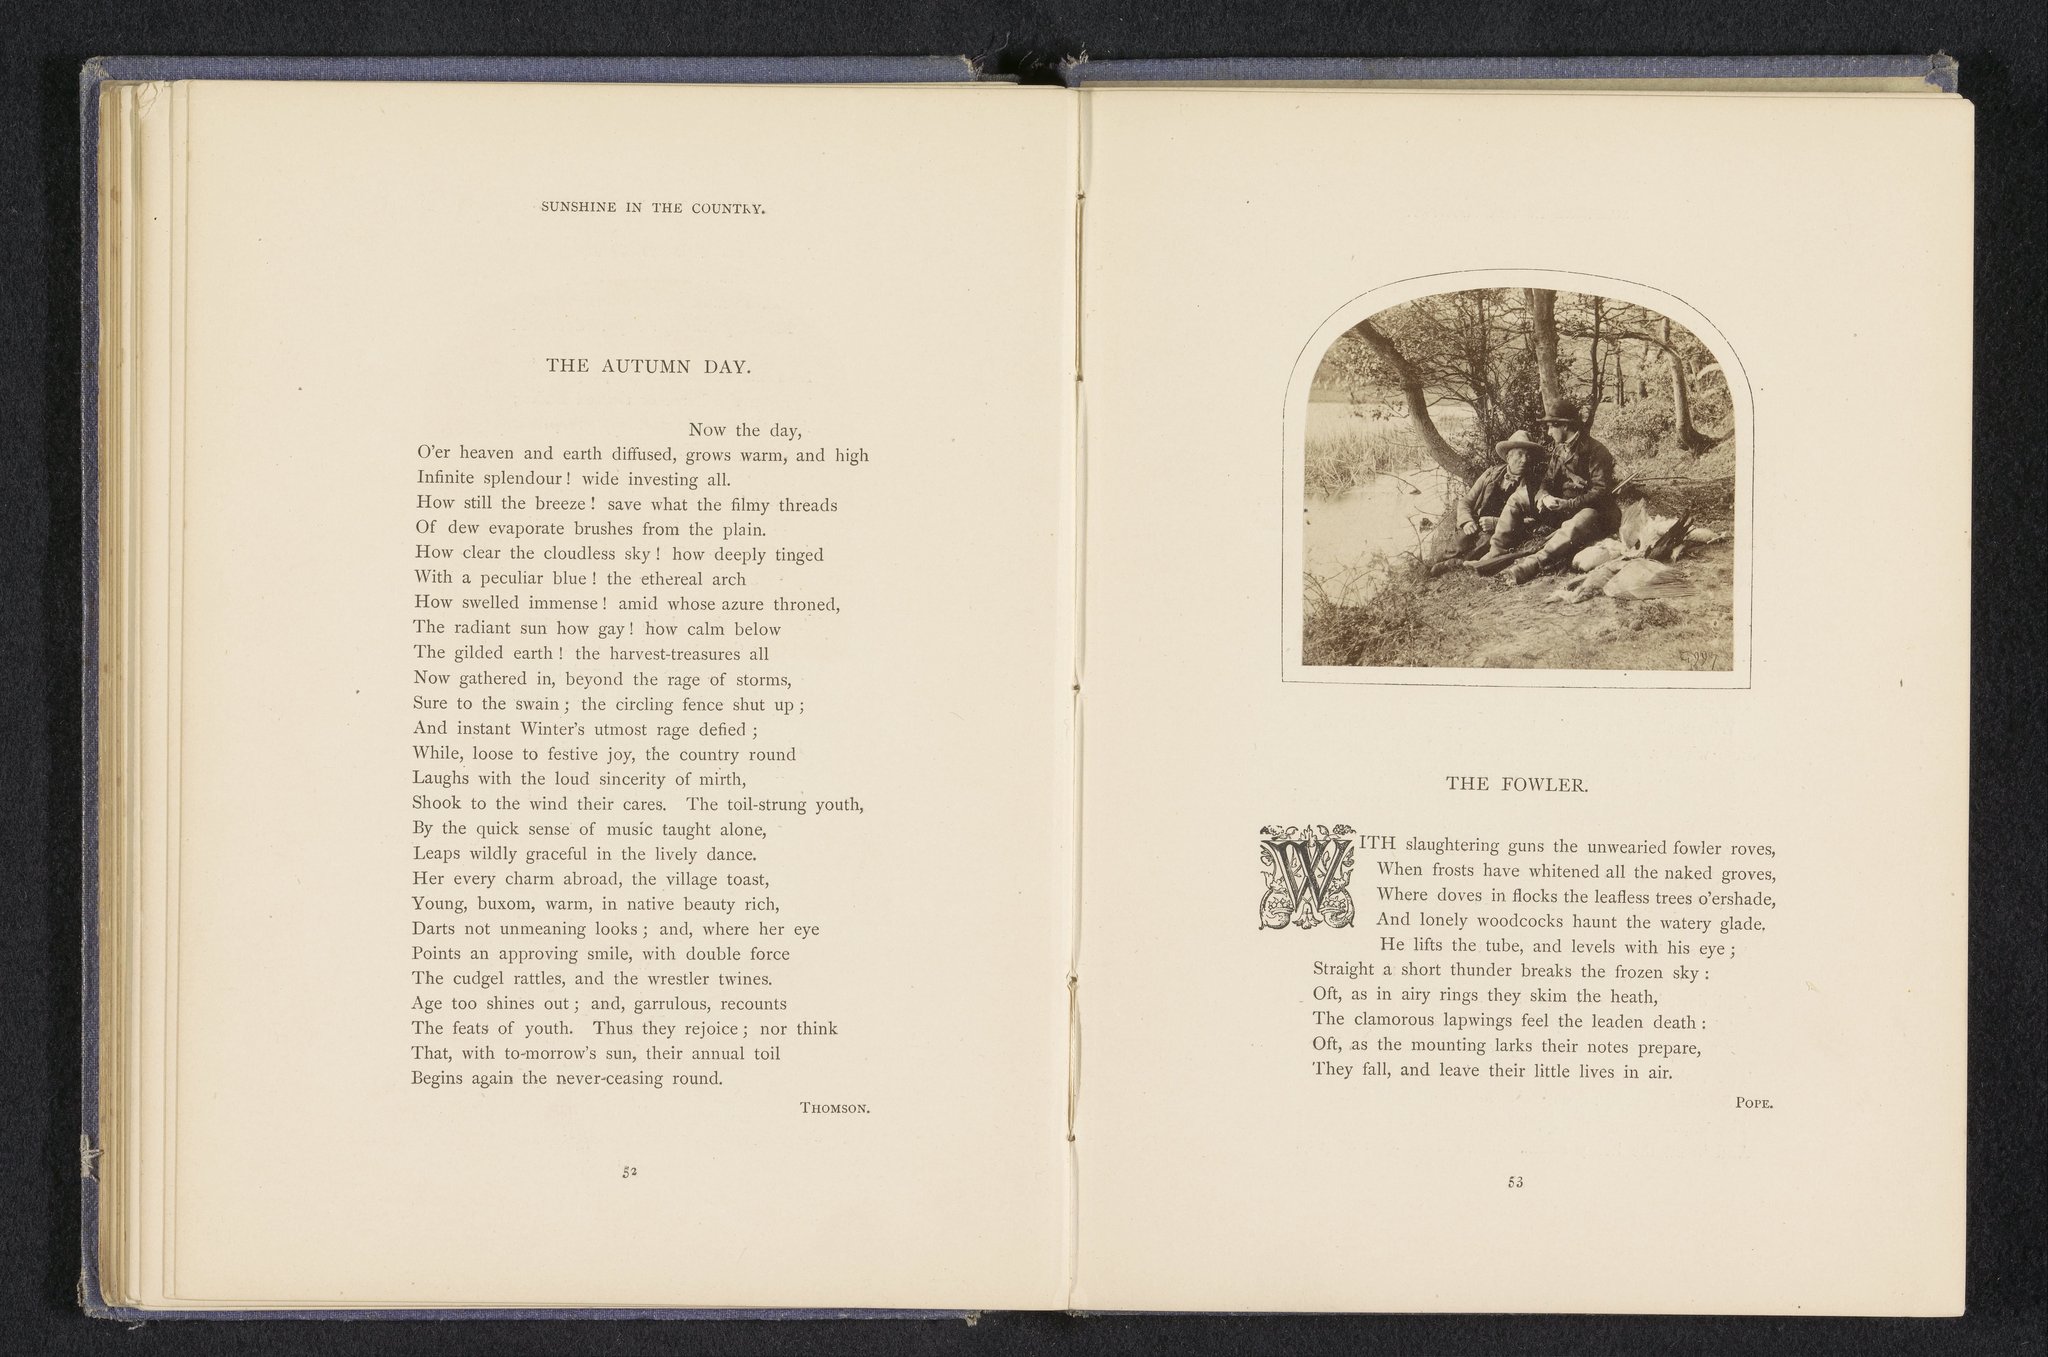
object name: photograph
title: Twee mannen zittend op een oever met naast zich dode vogels na de jacht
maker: william morris grundy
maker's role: fotograaf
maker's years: 1806-1859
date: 1851-1861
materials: photographic support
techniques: albumen print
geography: england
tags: game, hunted animals